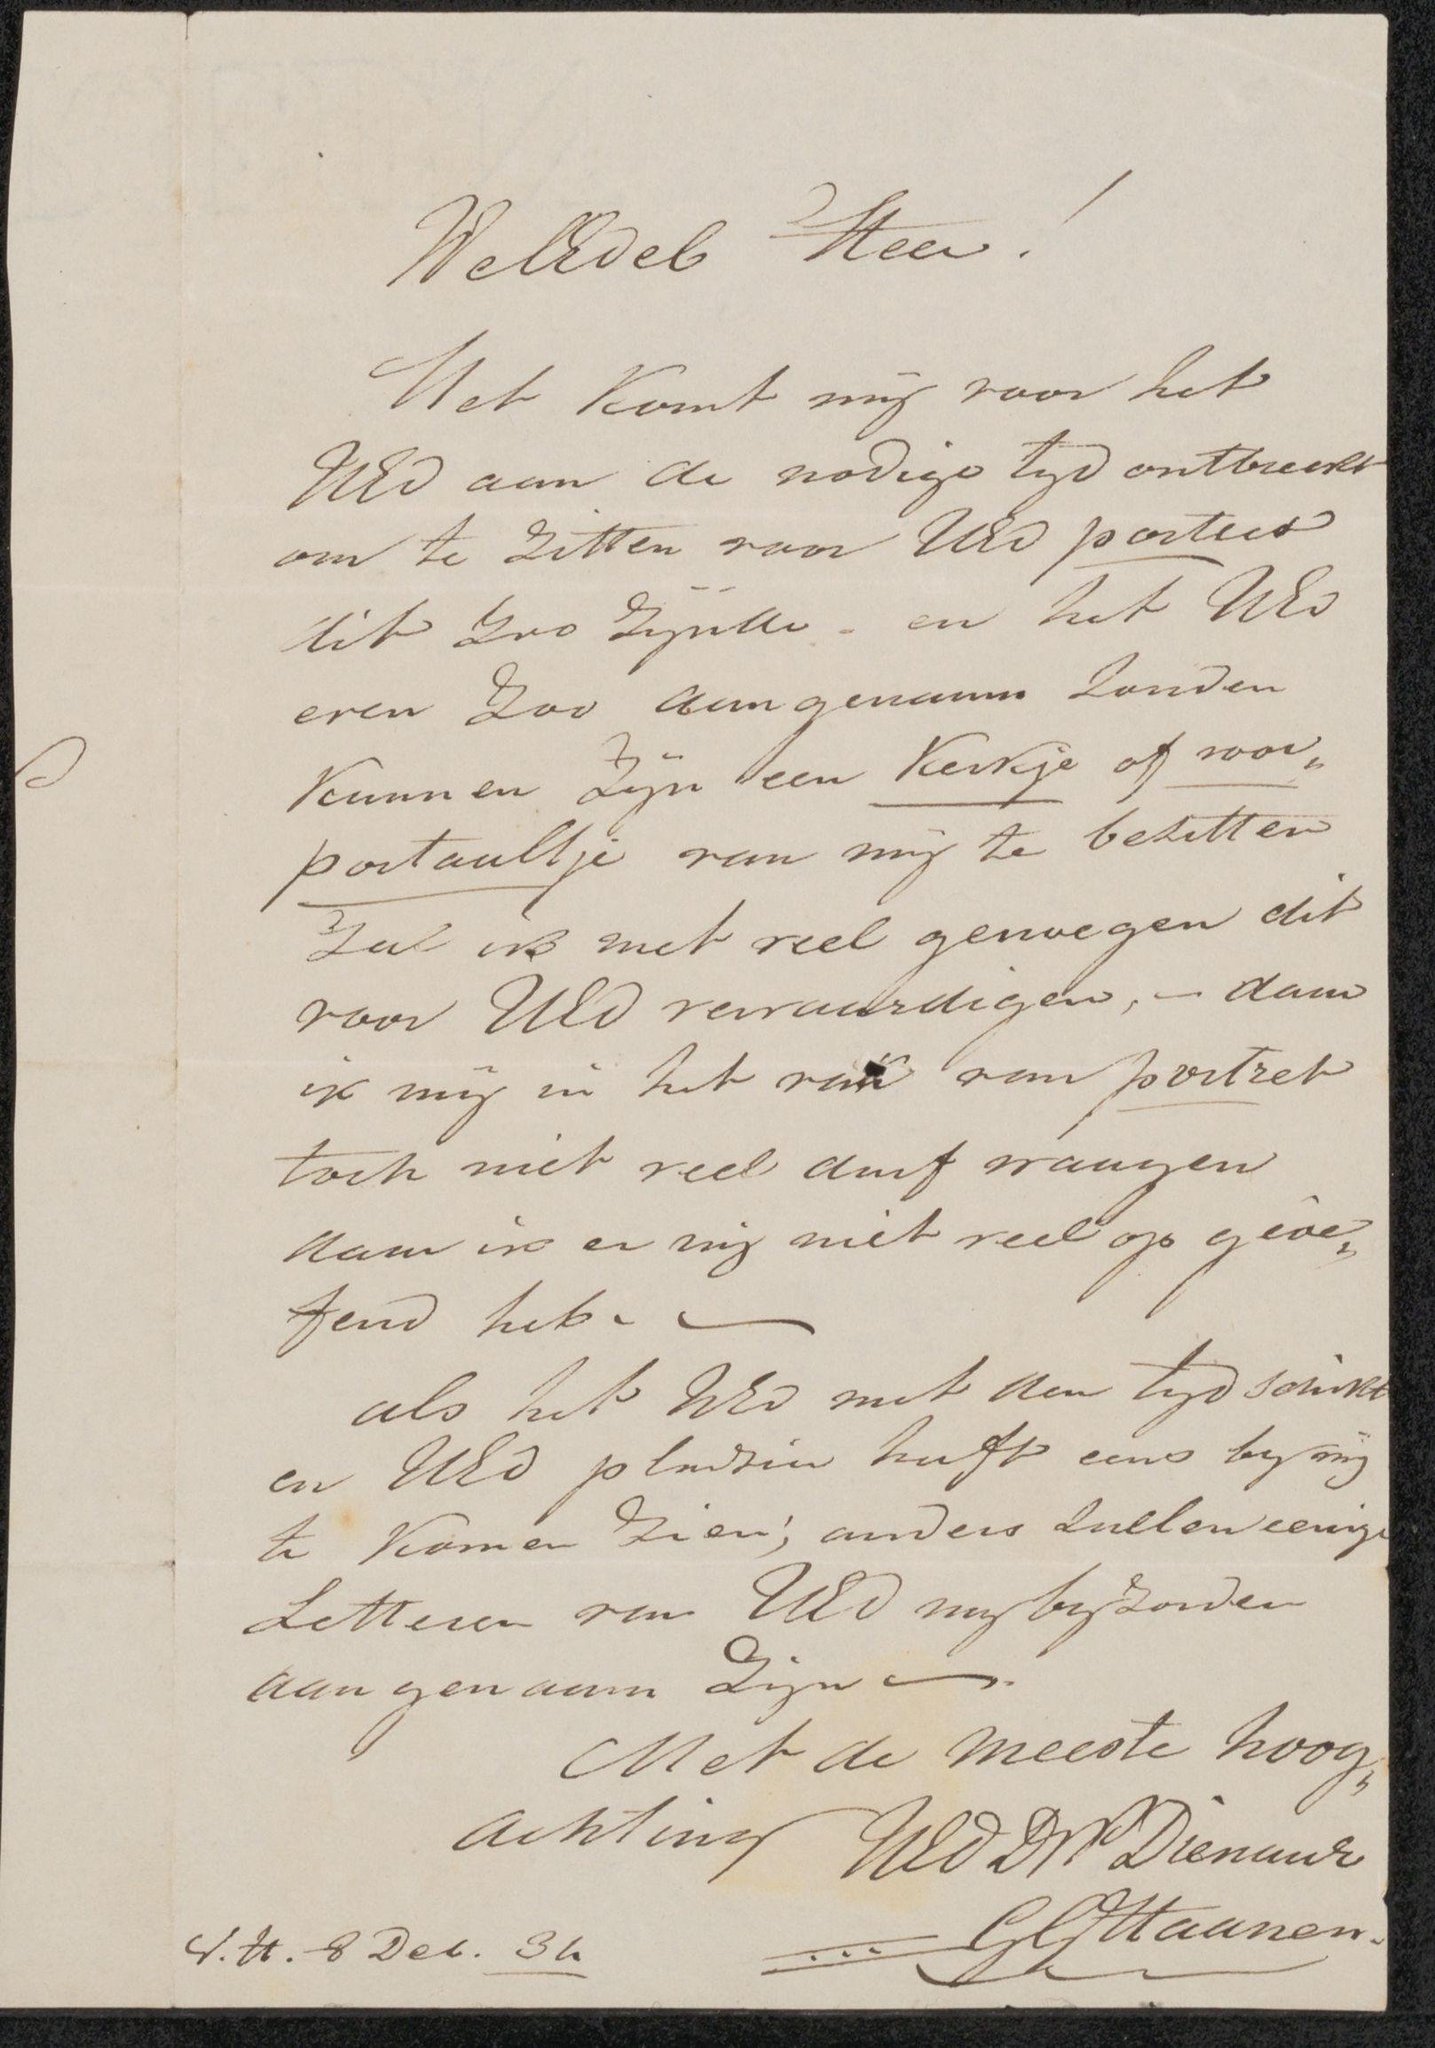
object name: letter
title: Brief aan anoniem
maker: george gillis haanen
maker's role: draughtsman, painter, print maker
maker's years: 1807-1881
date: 1834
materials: ink, paper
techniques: pen, writing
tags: artist's model, sitter, anonymous historical person portrayed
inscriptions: watermark